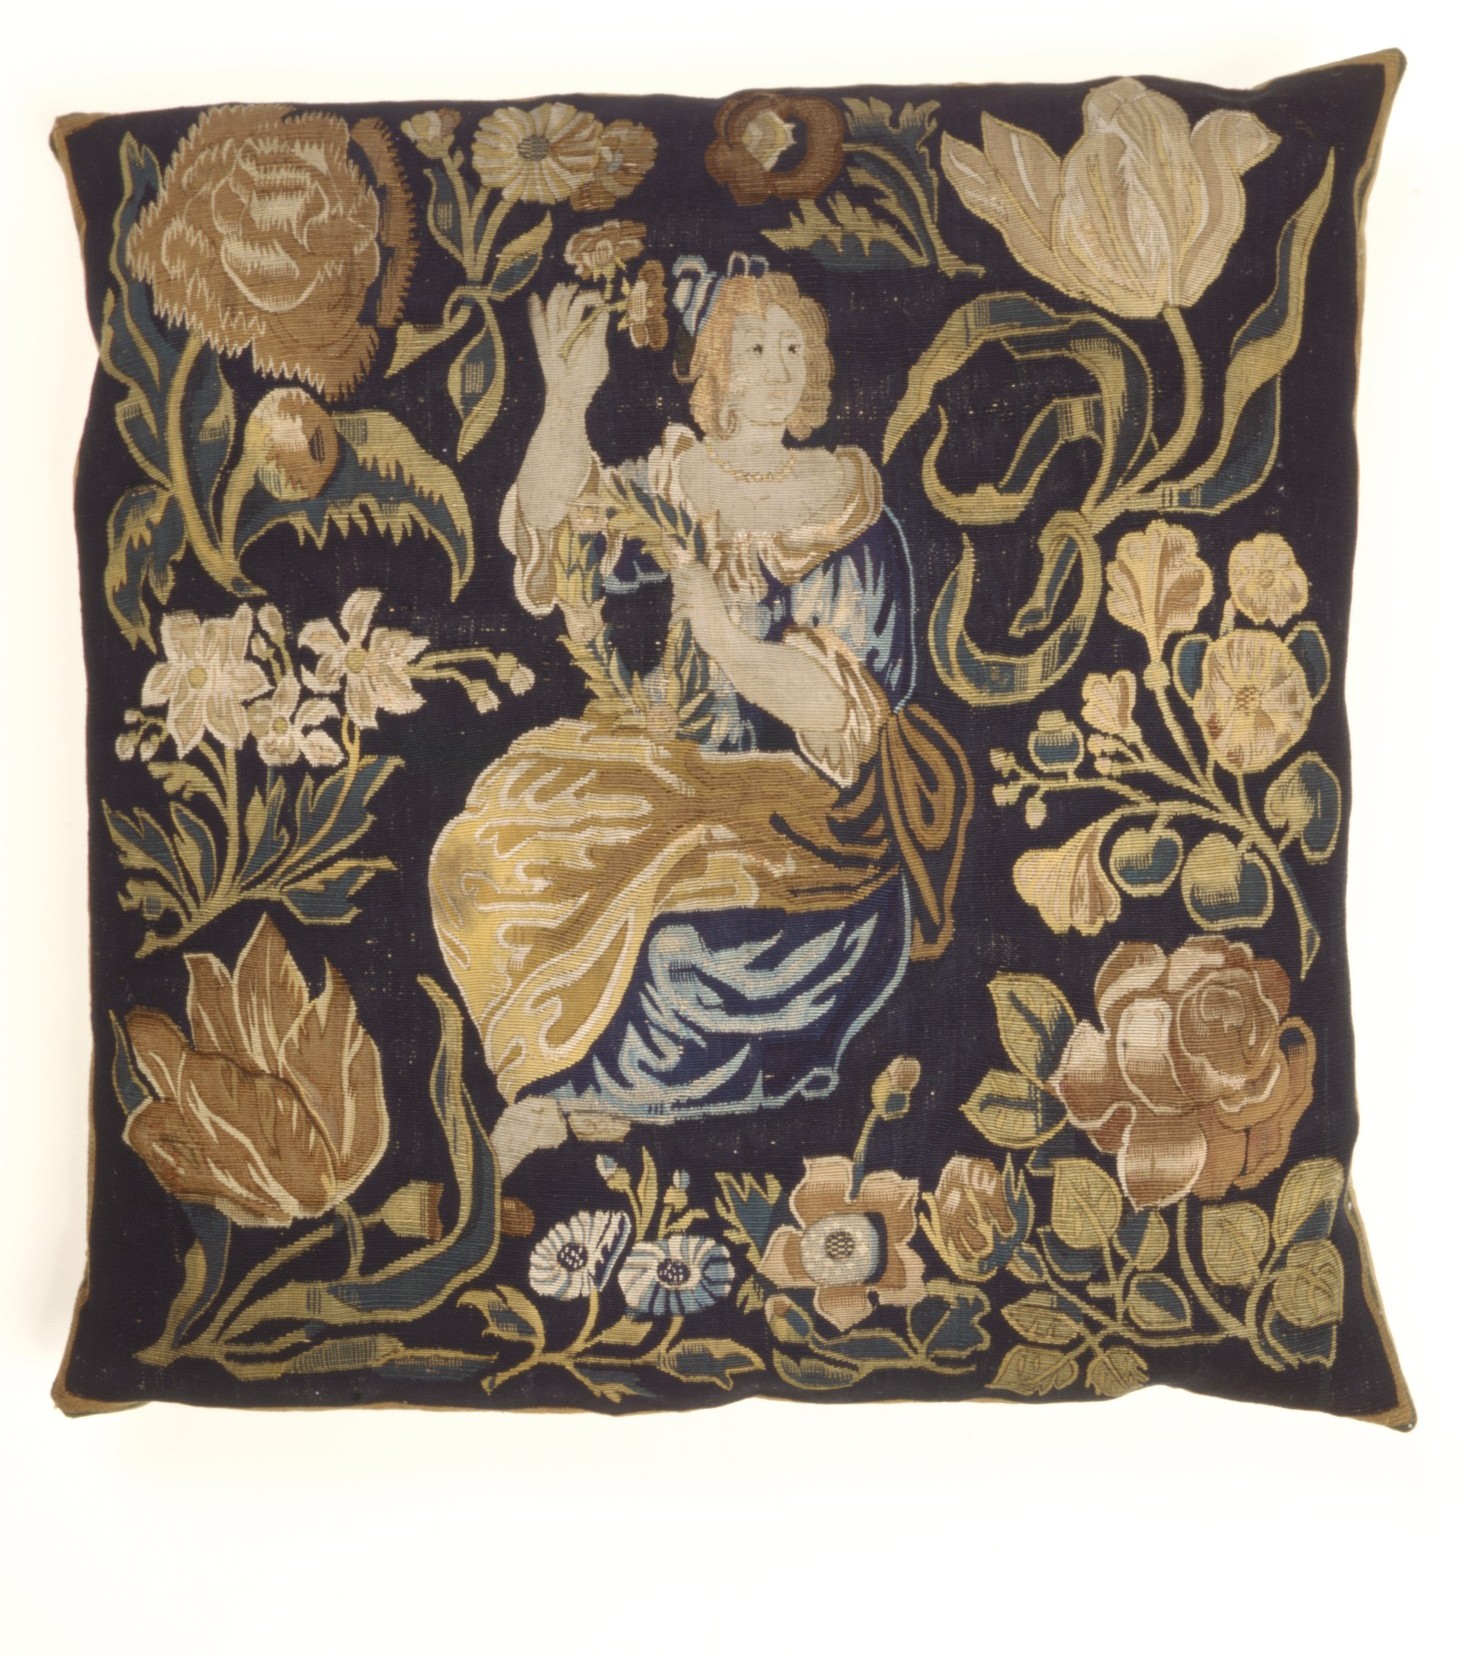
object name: cushion cover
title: Cushion Cover with "Scent"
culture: dutch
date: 1634-1666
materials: cotton, linen, silk, wool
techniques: weave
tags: women,flowers